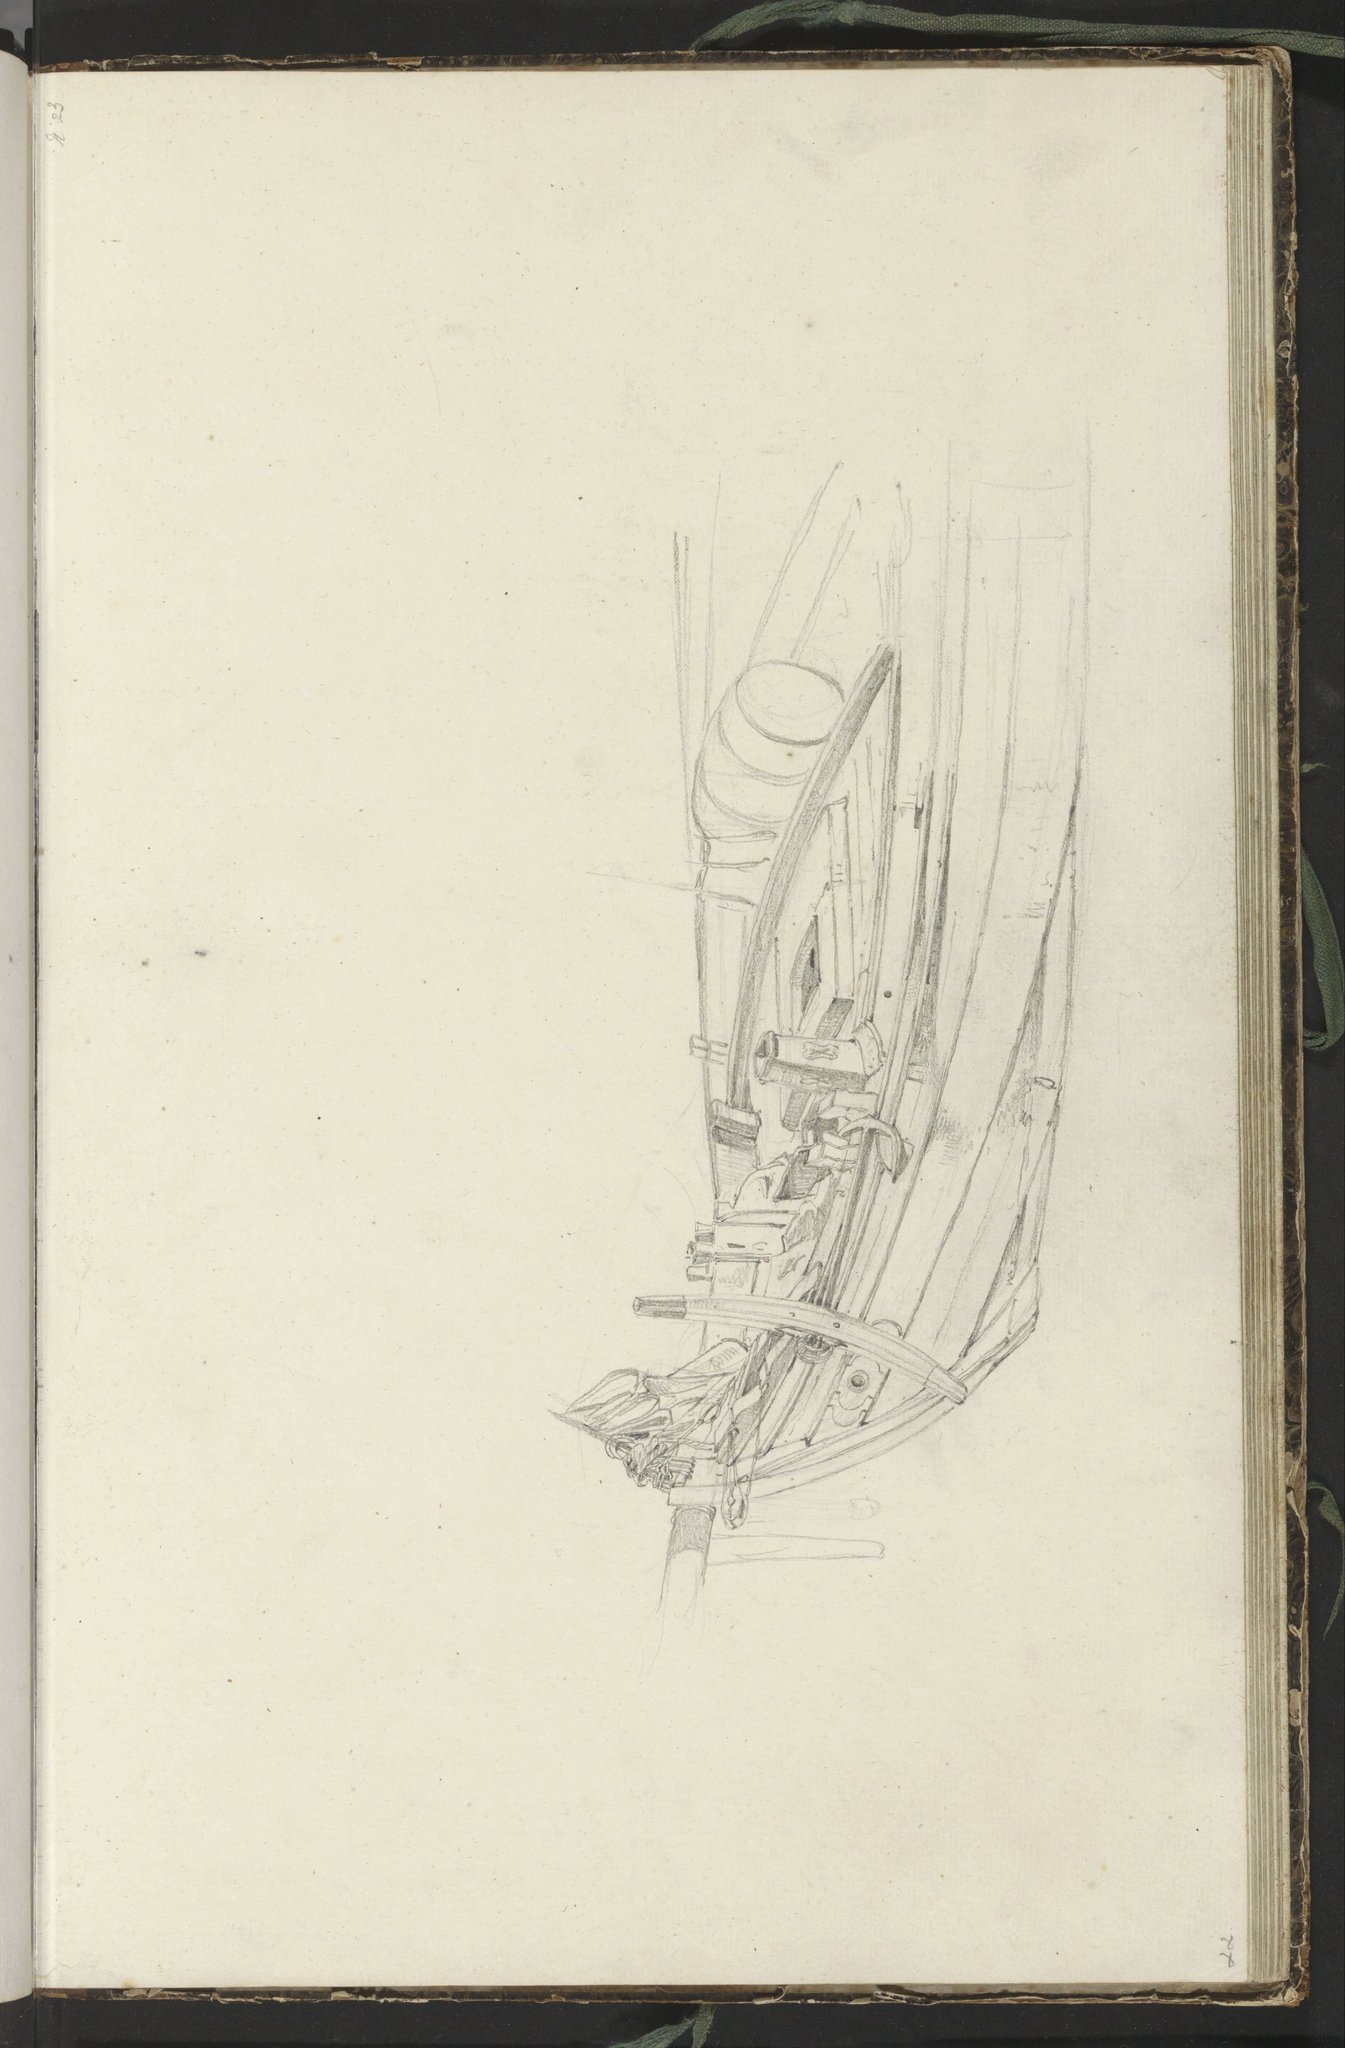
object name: sketchbook leaf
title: Boeg van een zeilboot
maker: johannes christiaan schotel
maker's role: draughtsman, painter, print maker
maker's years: 1787-1838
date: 1797-1838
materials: paper, pencil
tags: sailing-ship, sailing-boat, parts of ship's exterior: bow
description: Blad 22 recto uit een schetsboek met 44 bladen.